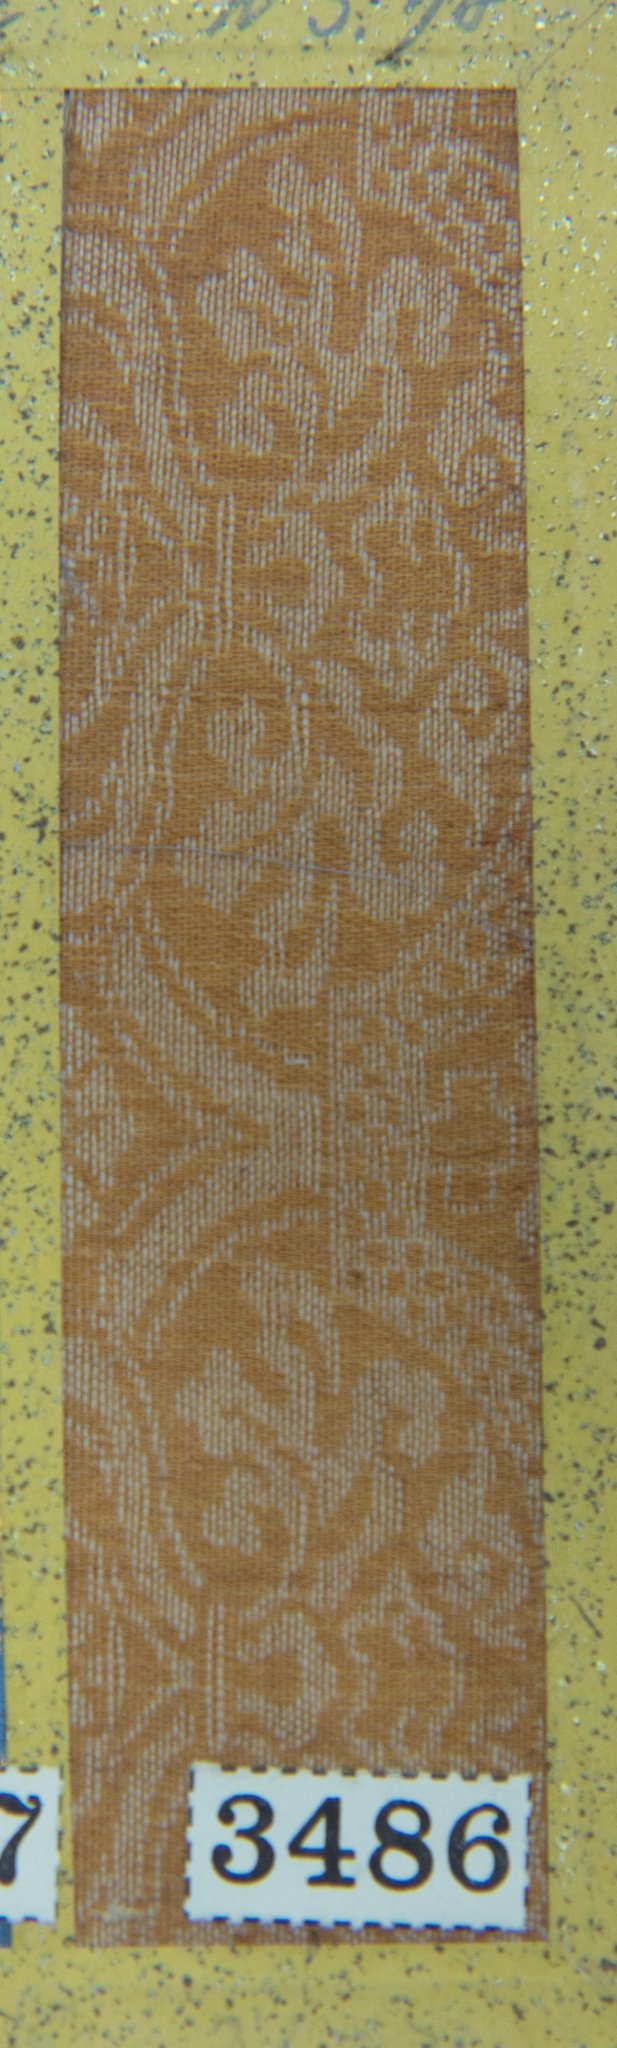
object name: sample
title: Textile Sample from Sample Book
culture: japanese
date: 1801-1900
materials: silk